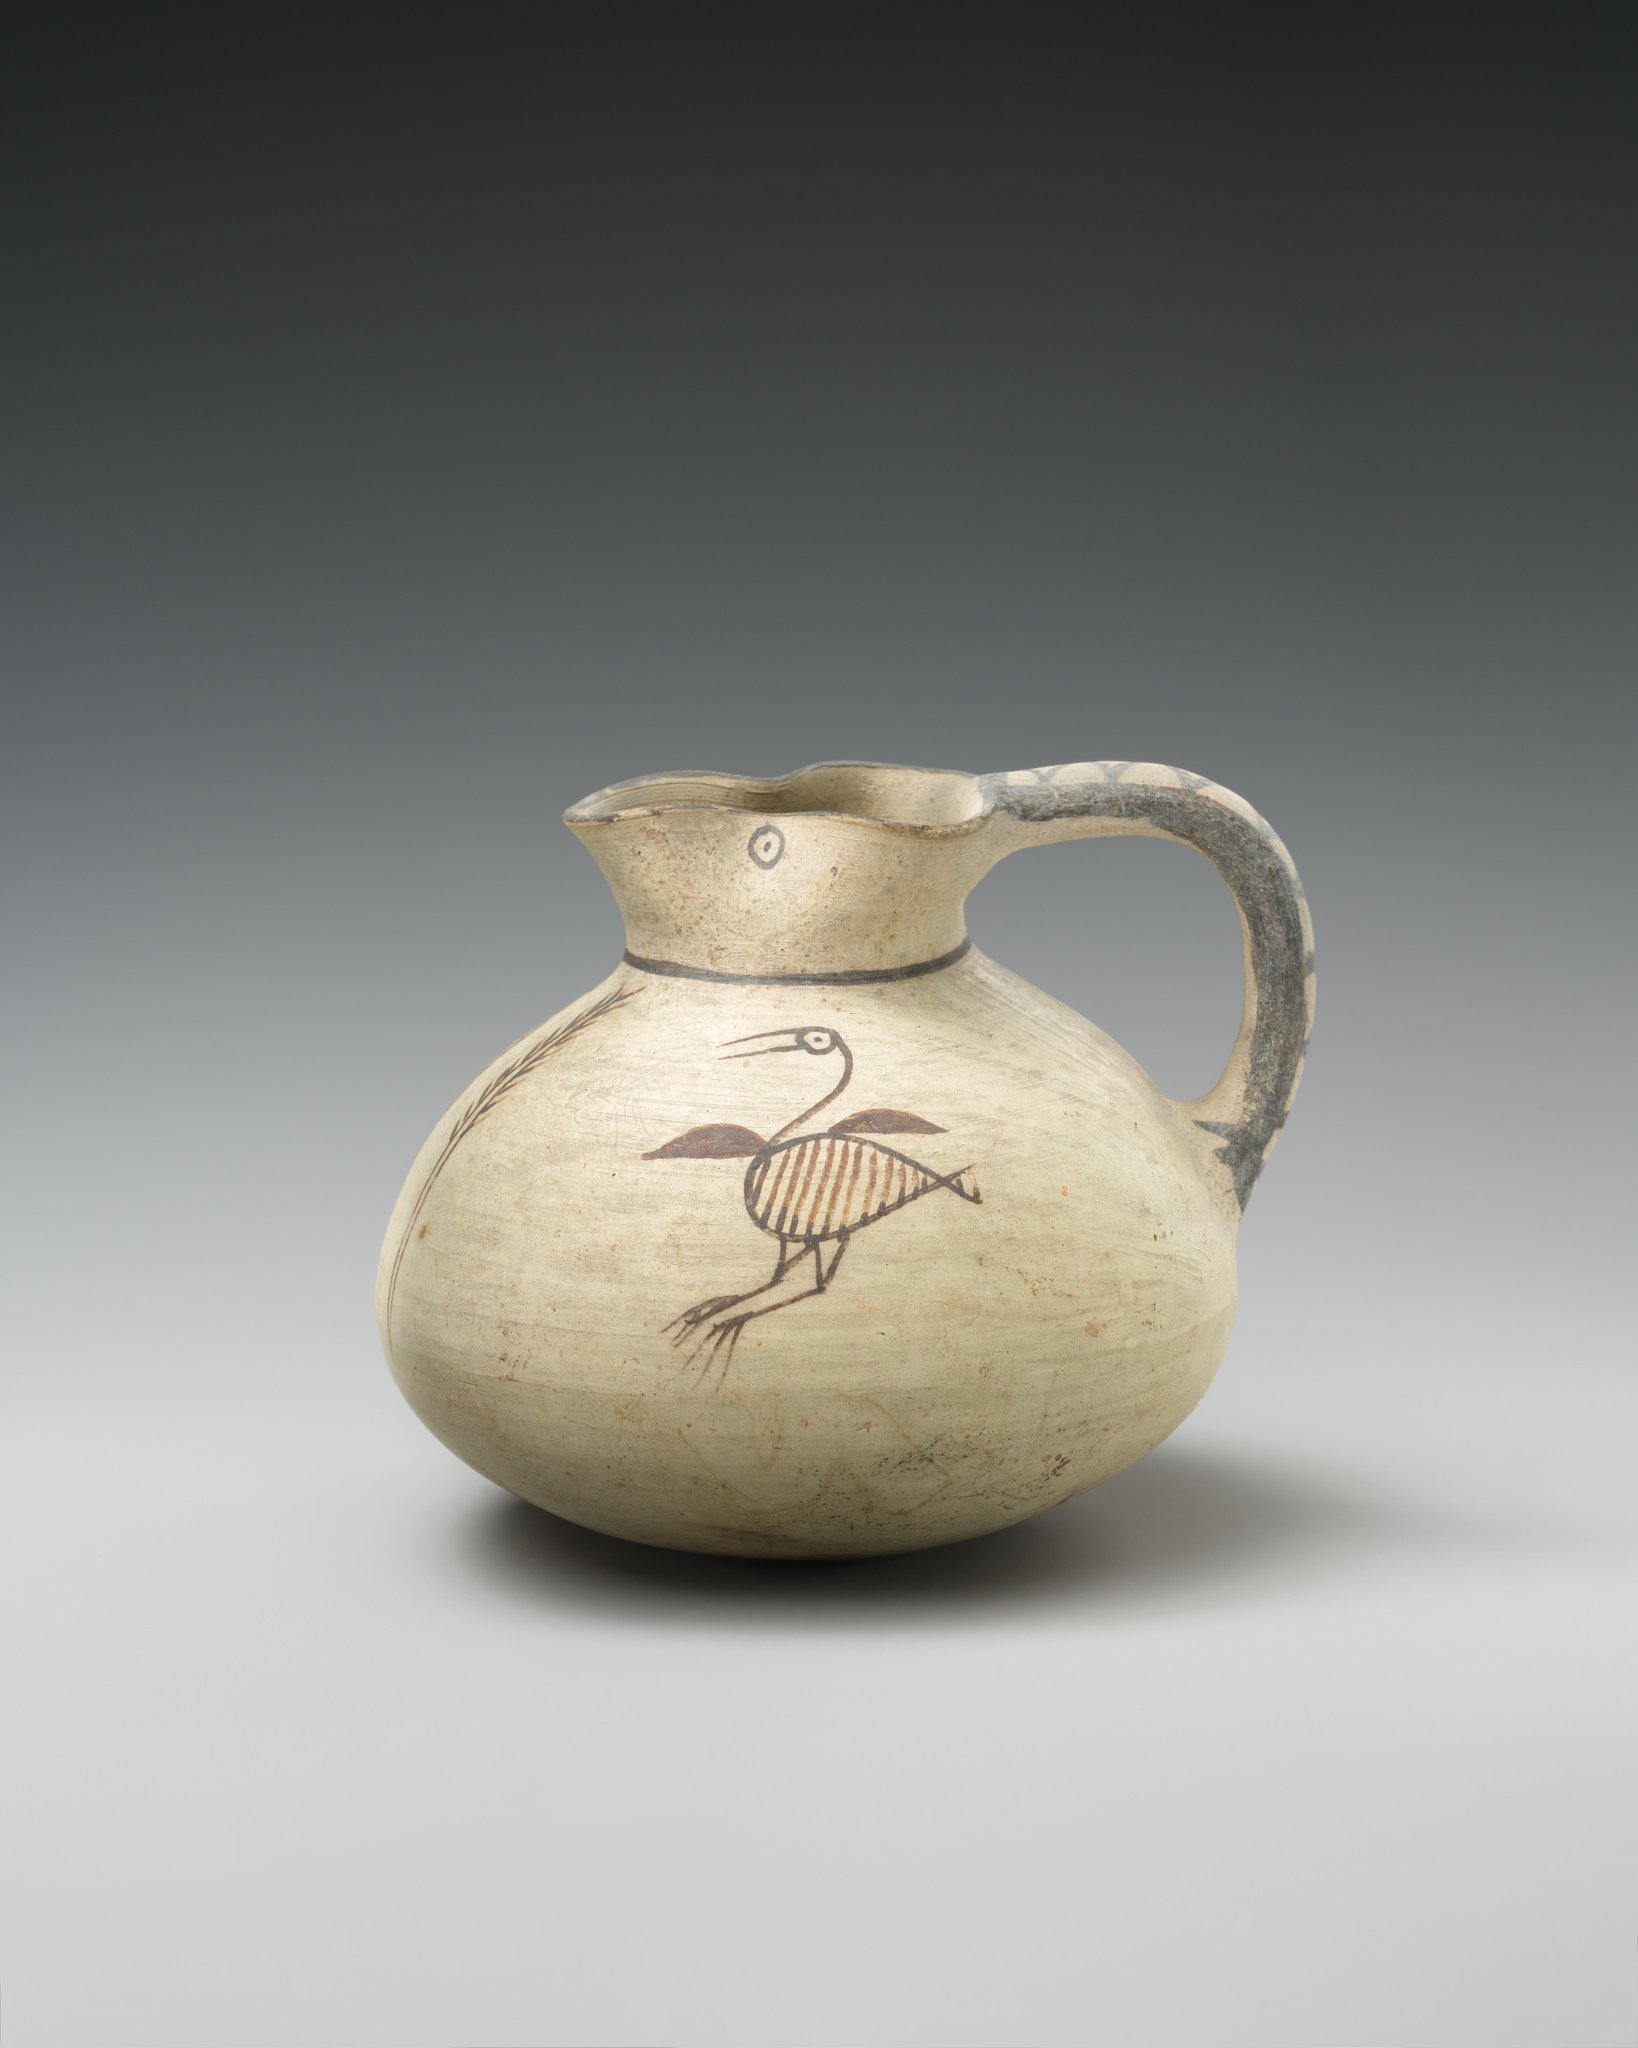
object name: juglet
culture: cypriot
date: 750-600 BCE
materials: terracotta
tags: birds